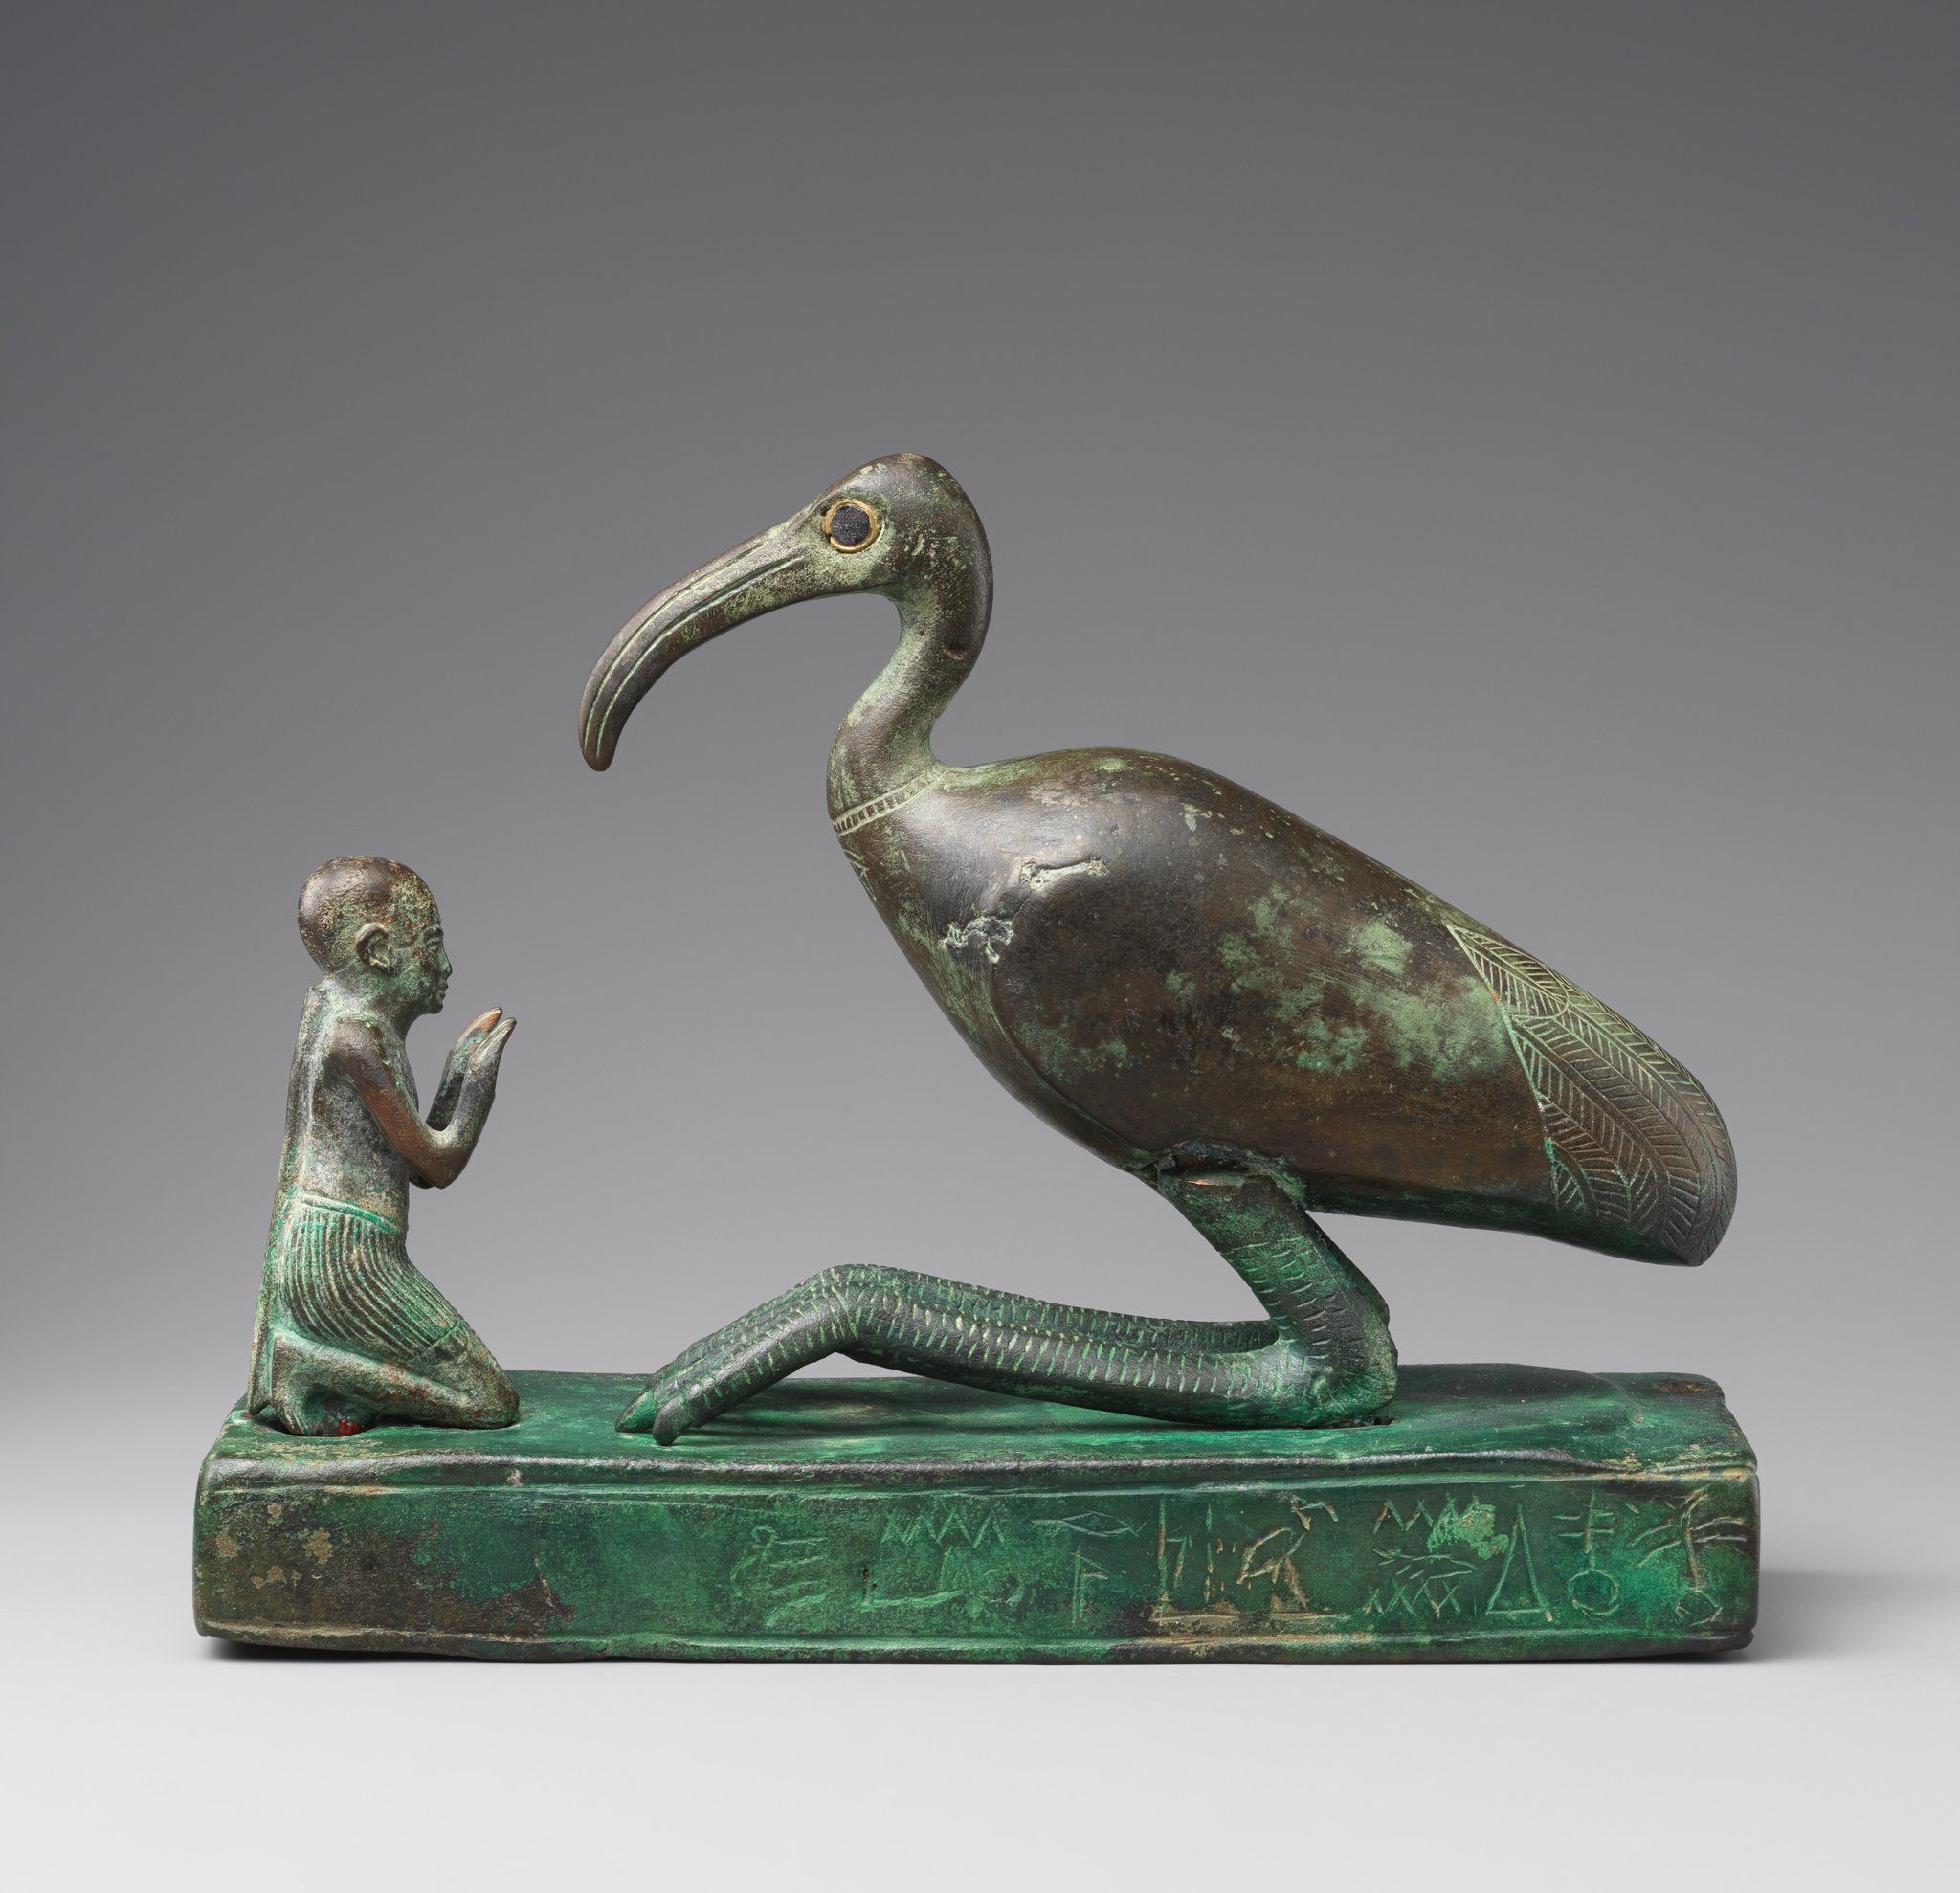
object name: statue group, ibis, devotee, padihorsiese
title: Group statue of Thoth-ibis and devotee on a base inscribed for Padihorsiese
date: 664-525 BCE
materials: metal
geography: egypt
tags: birds,men